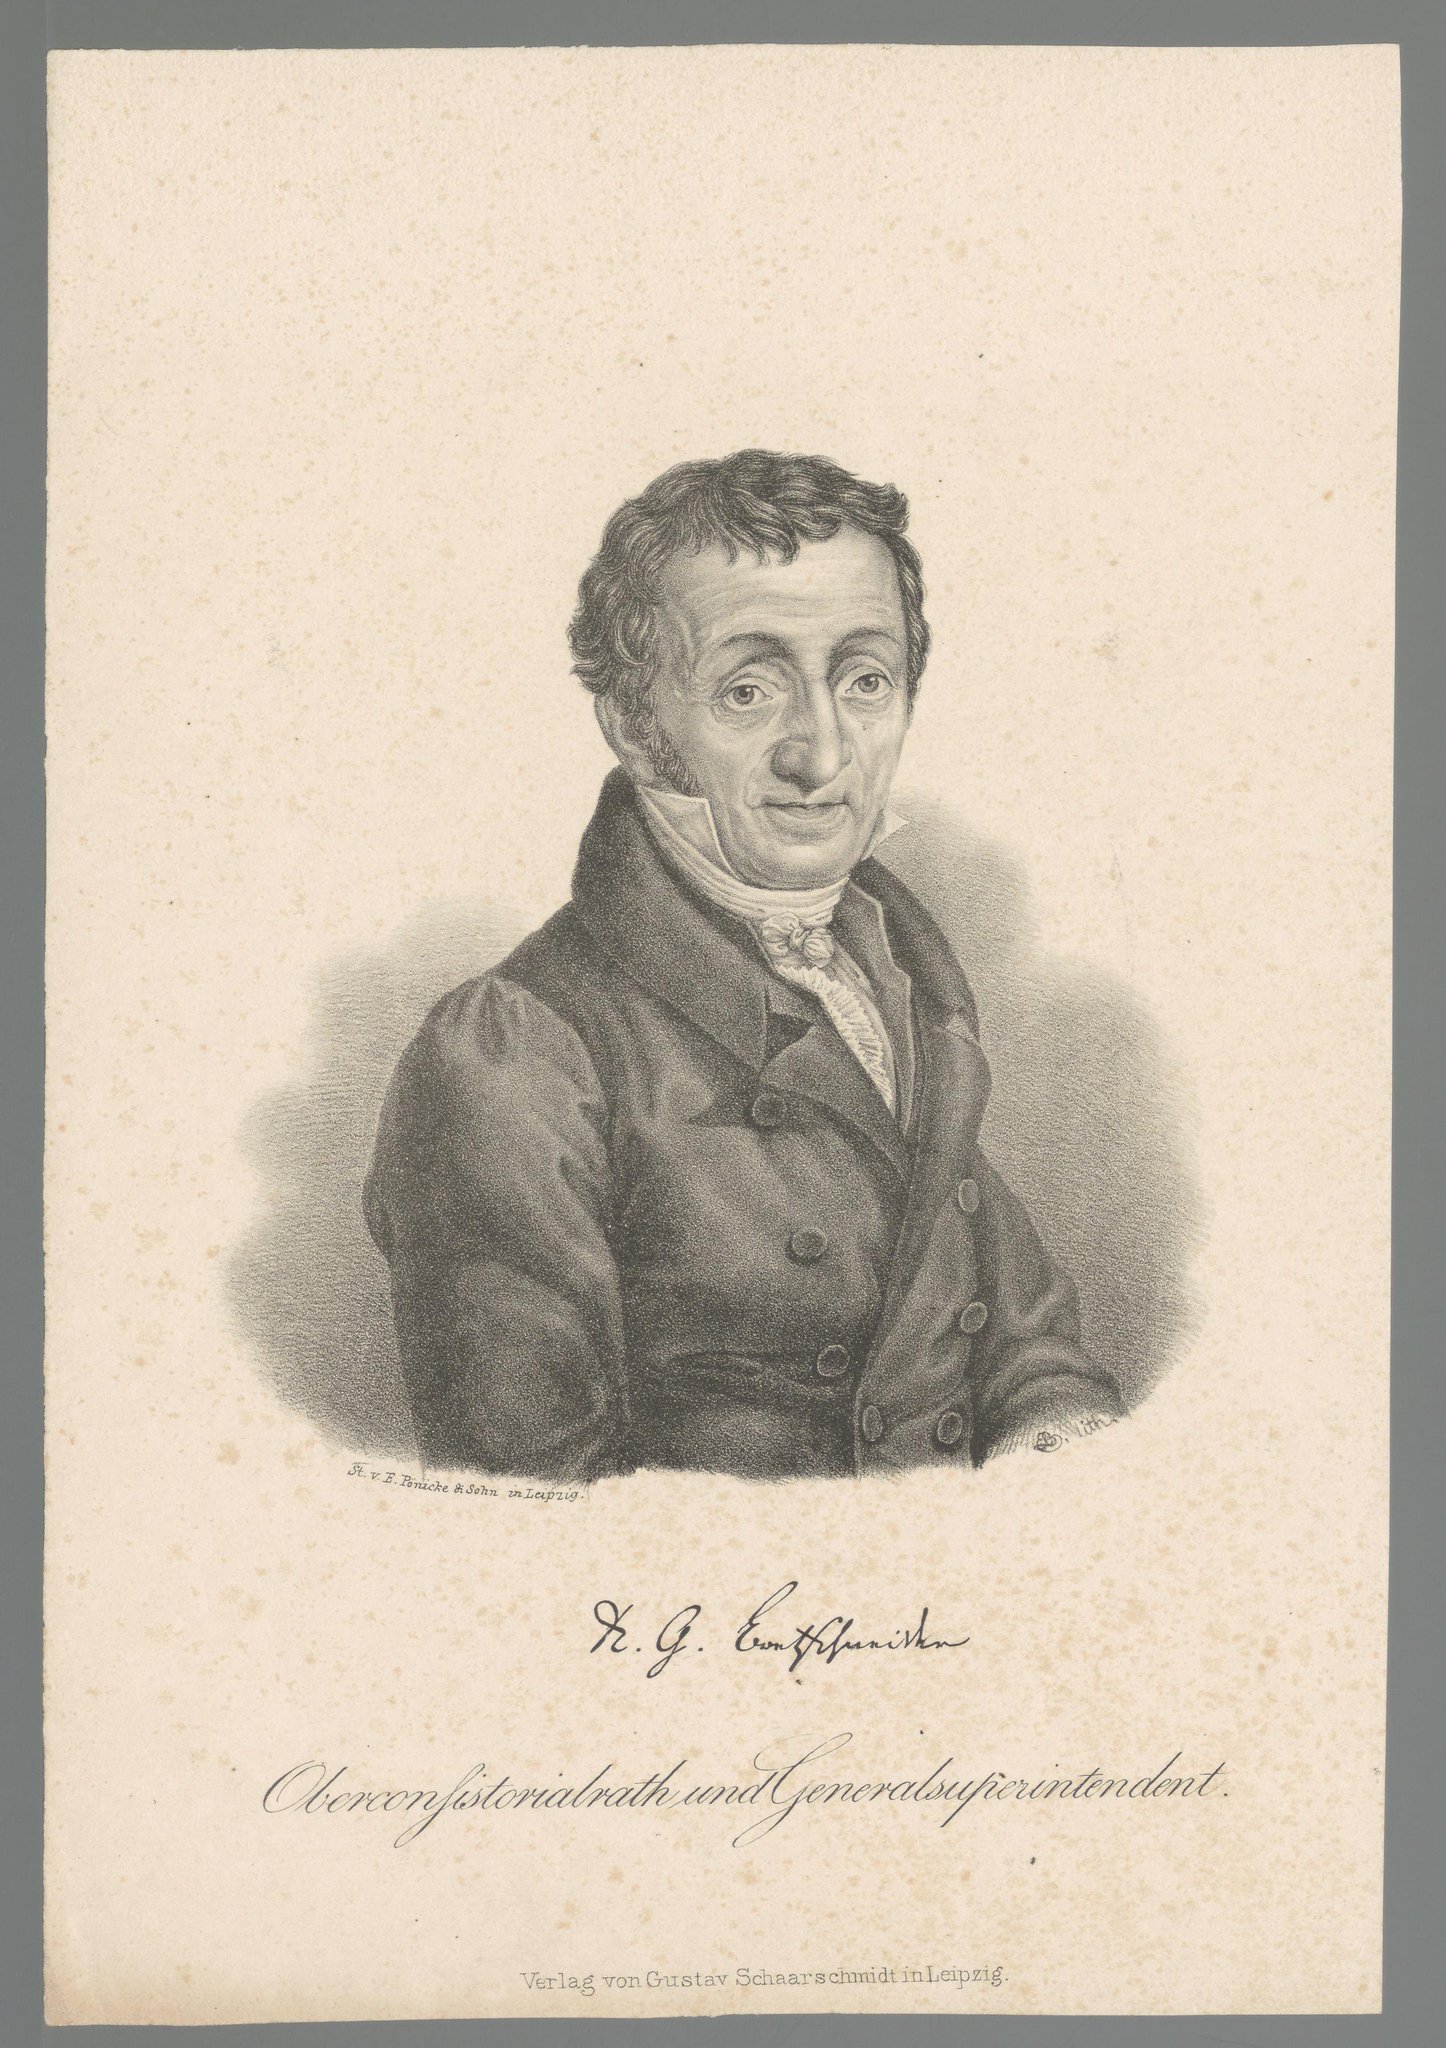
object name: print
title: Portret van een onbekende man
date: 1840-1848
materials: paper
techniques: lithograph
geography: leipzig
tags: adult man, historical persons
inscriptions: monogram: ‘[EB]’, collector's mark: Lugt 2228